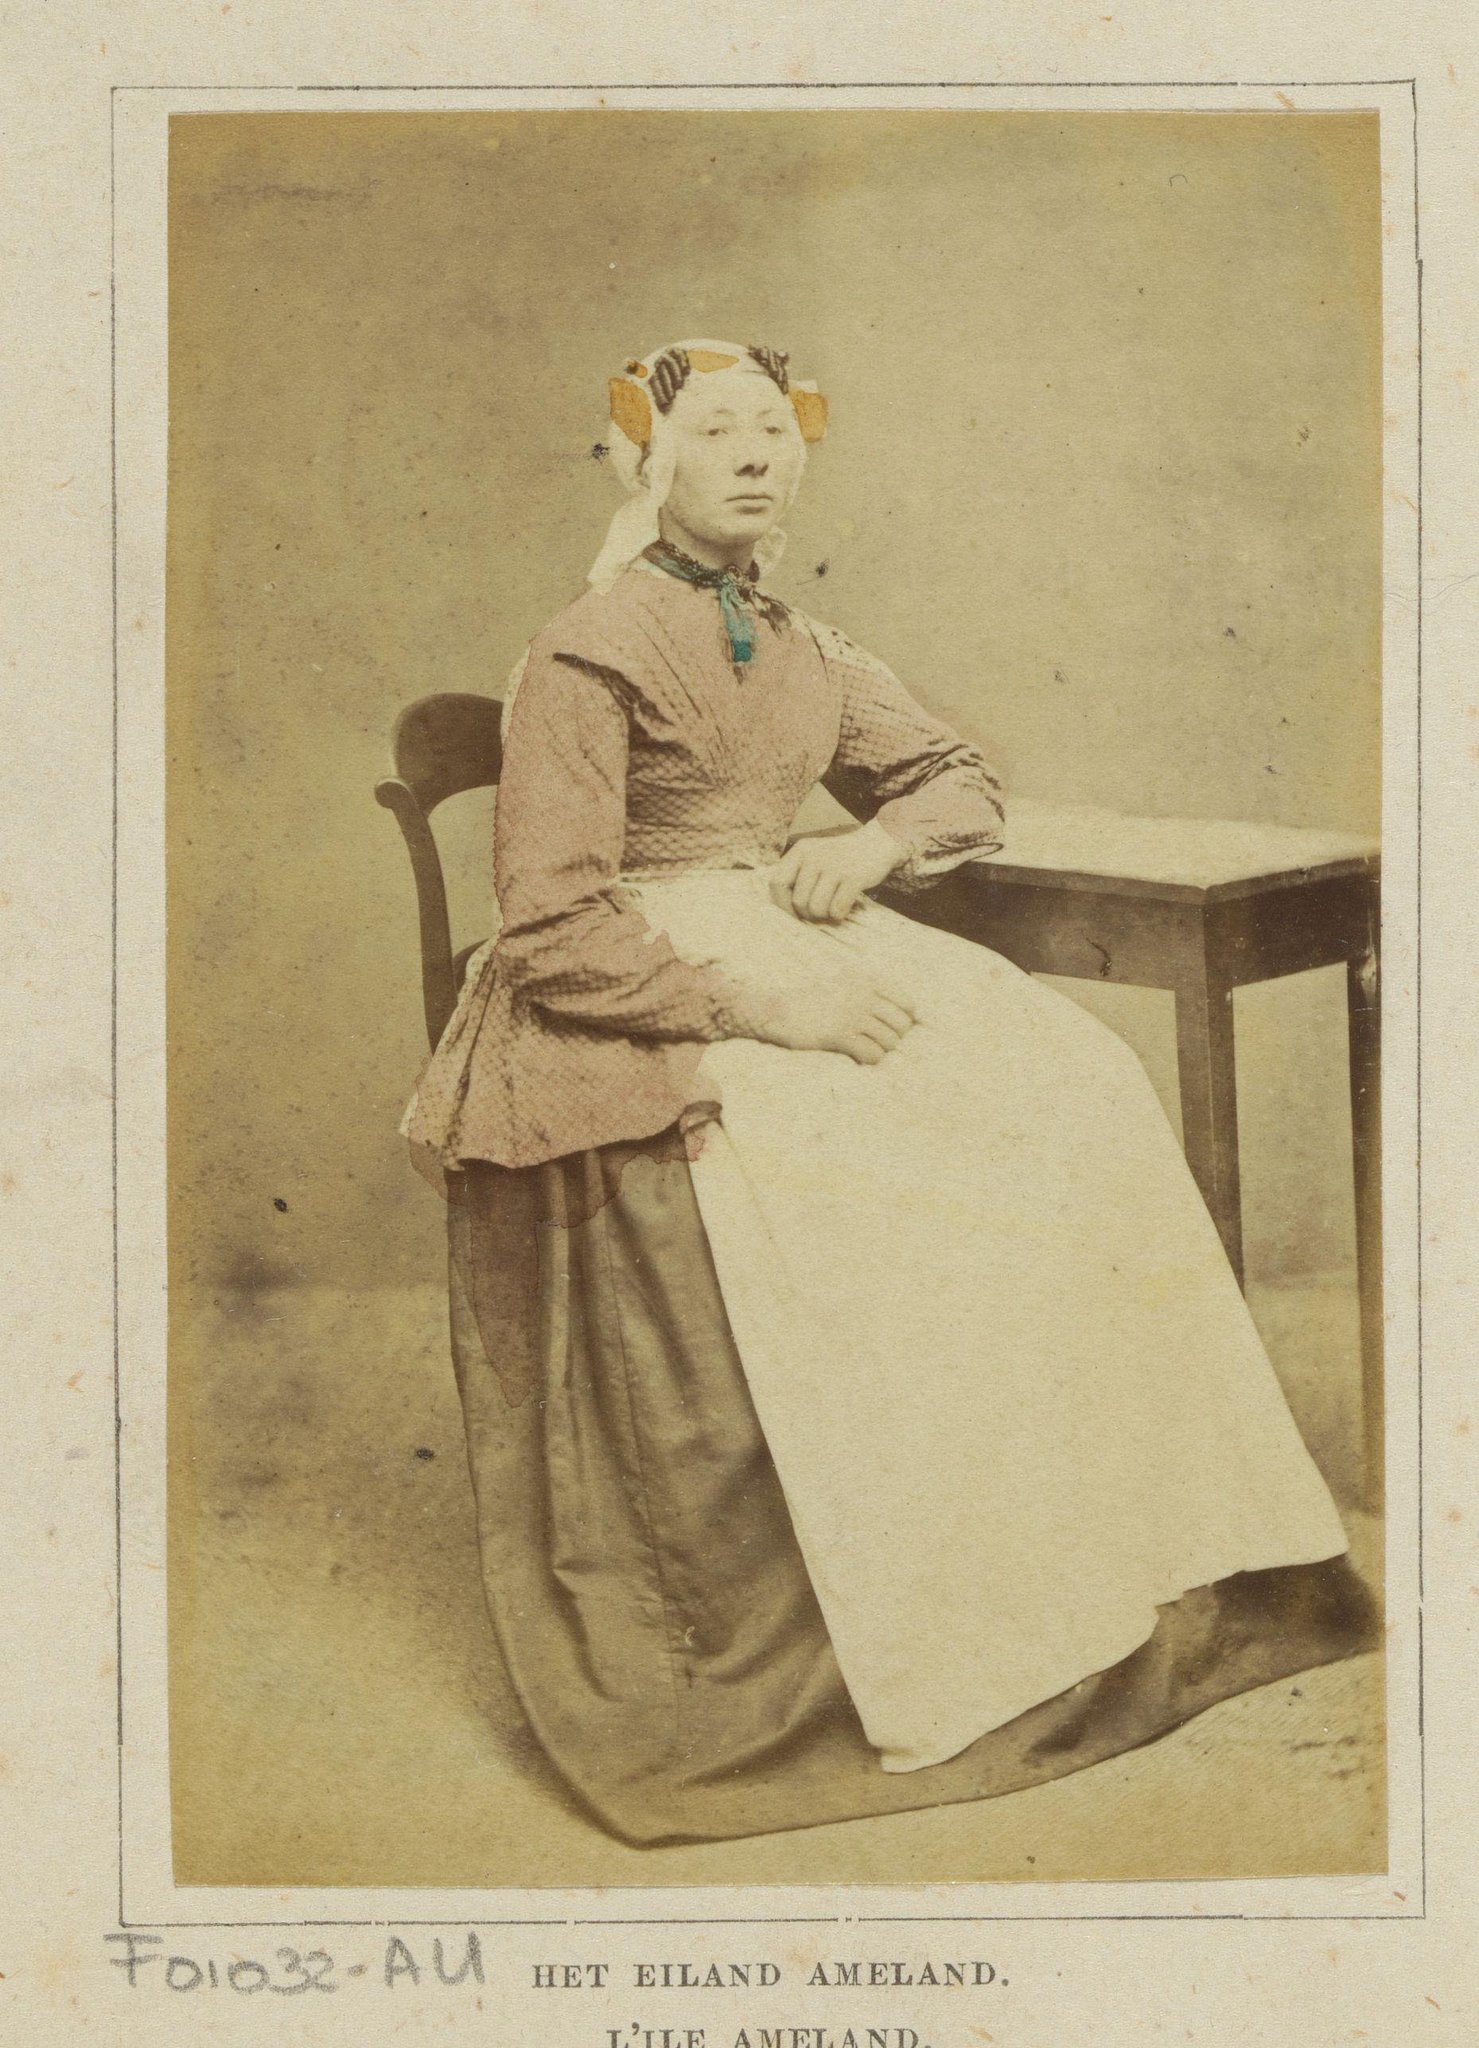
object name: photograph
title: L'Ile Ameland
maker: andries jager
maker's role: publisher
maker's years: 1825-1905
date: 1860-1890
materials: cardboard, photographic support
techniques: albumen print, hand coloring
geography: amsterdam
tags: folk costume, regional costume (+ women's clothes), historical persons - bb - woman, europeans (with name), netherlands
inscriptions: inscription: ‘Uitgave van A. JAGER, Water 110 te Amsterdam.’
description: Deze foto maakt deel uit van een omslag met 48 foto's op 12 bladen.